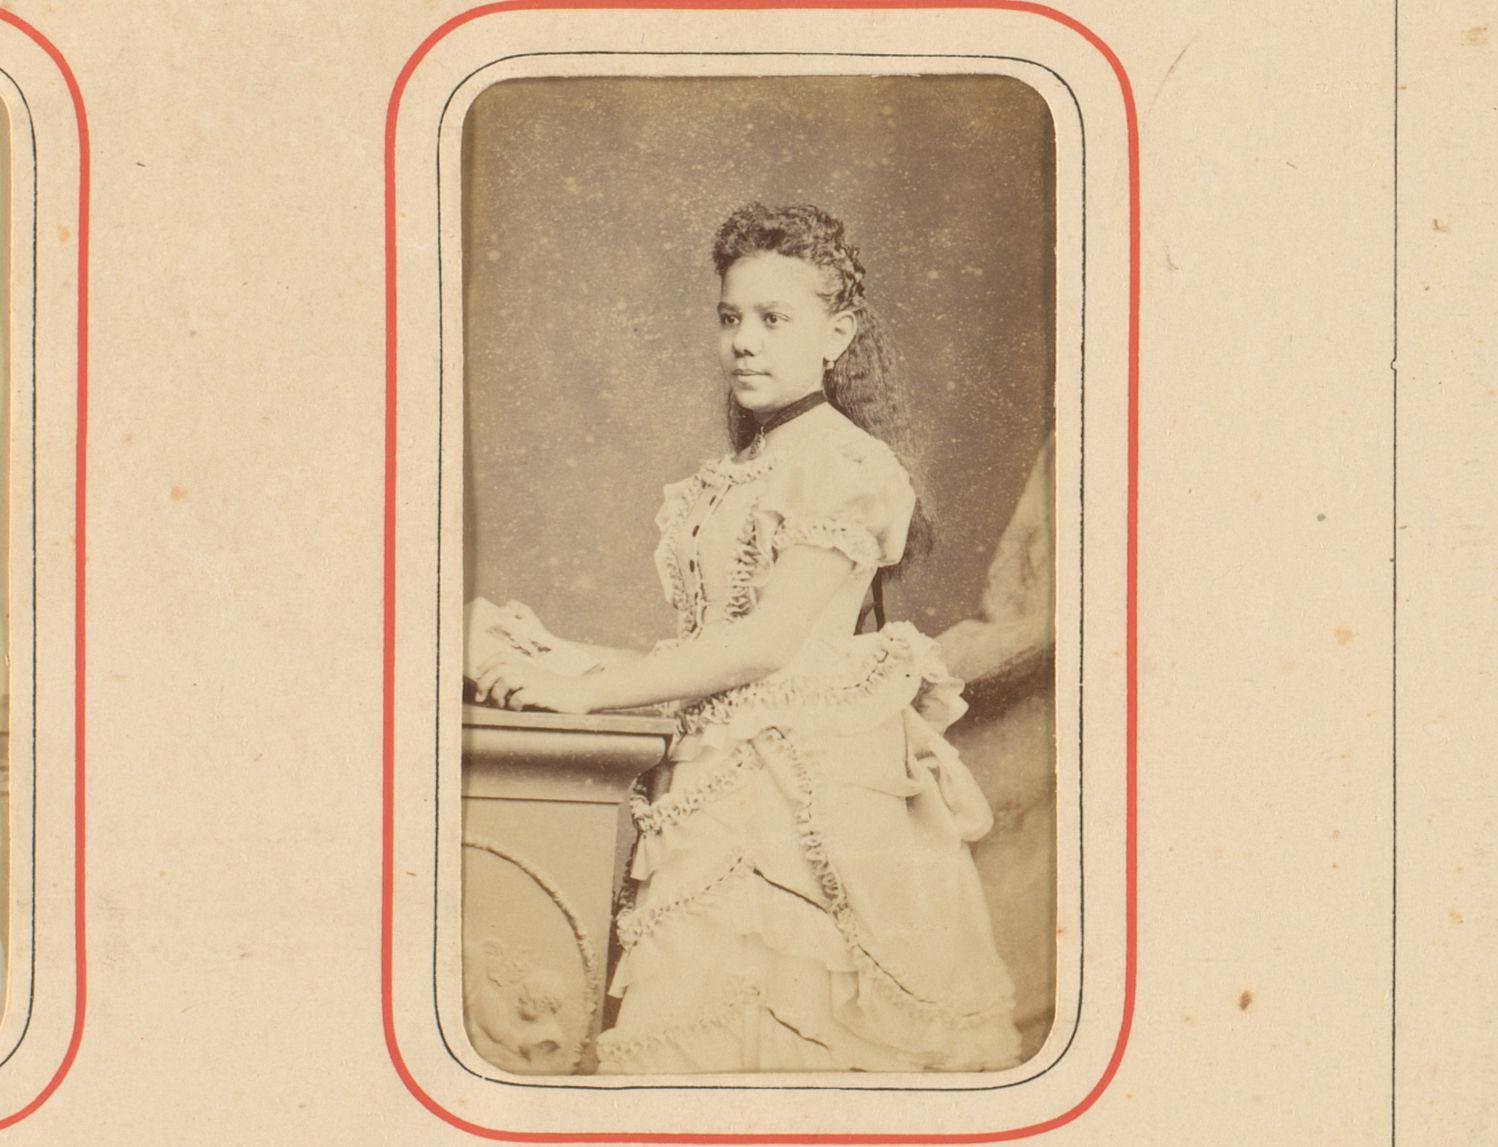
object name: photograph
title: Portret van een onbekend meisje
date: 1870-1890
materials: cardboard, paper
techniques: albumen print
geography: batavia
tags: anonymous historical person portrayed - bb - woman